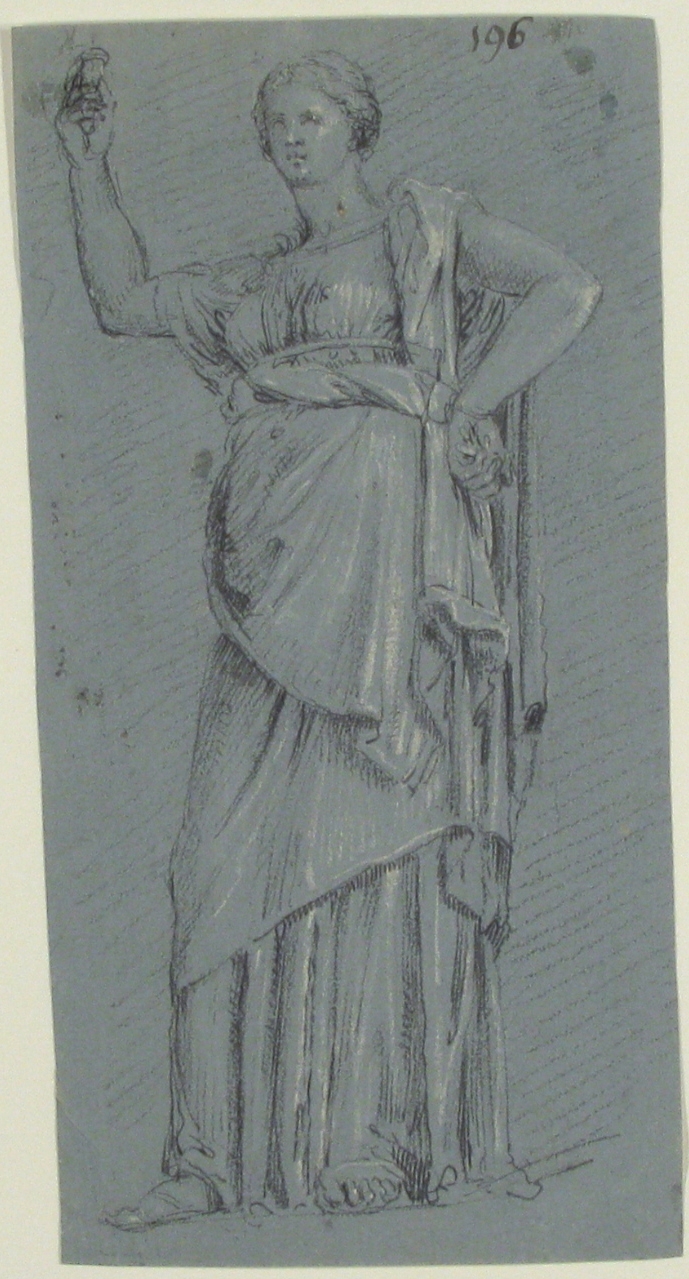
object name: drawing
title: Drawing after the "Juno Cesi"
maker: anonymous, french, 18th century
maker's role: artist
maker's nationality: french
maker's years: 1700-1800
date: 1701-1800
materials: graphite, paper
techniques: heightening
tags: women